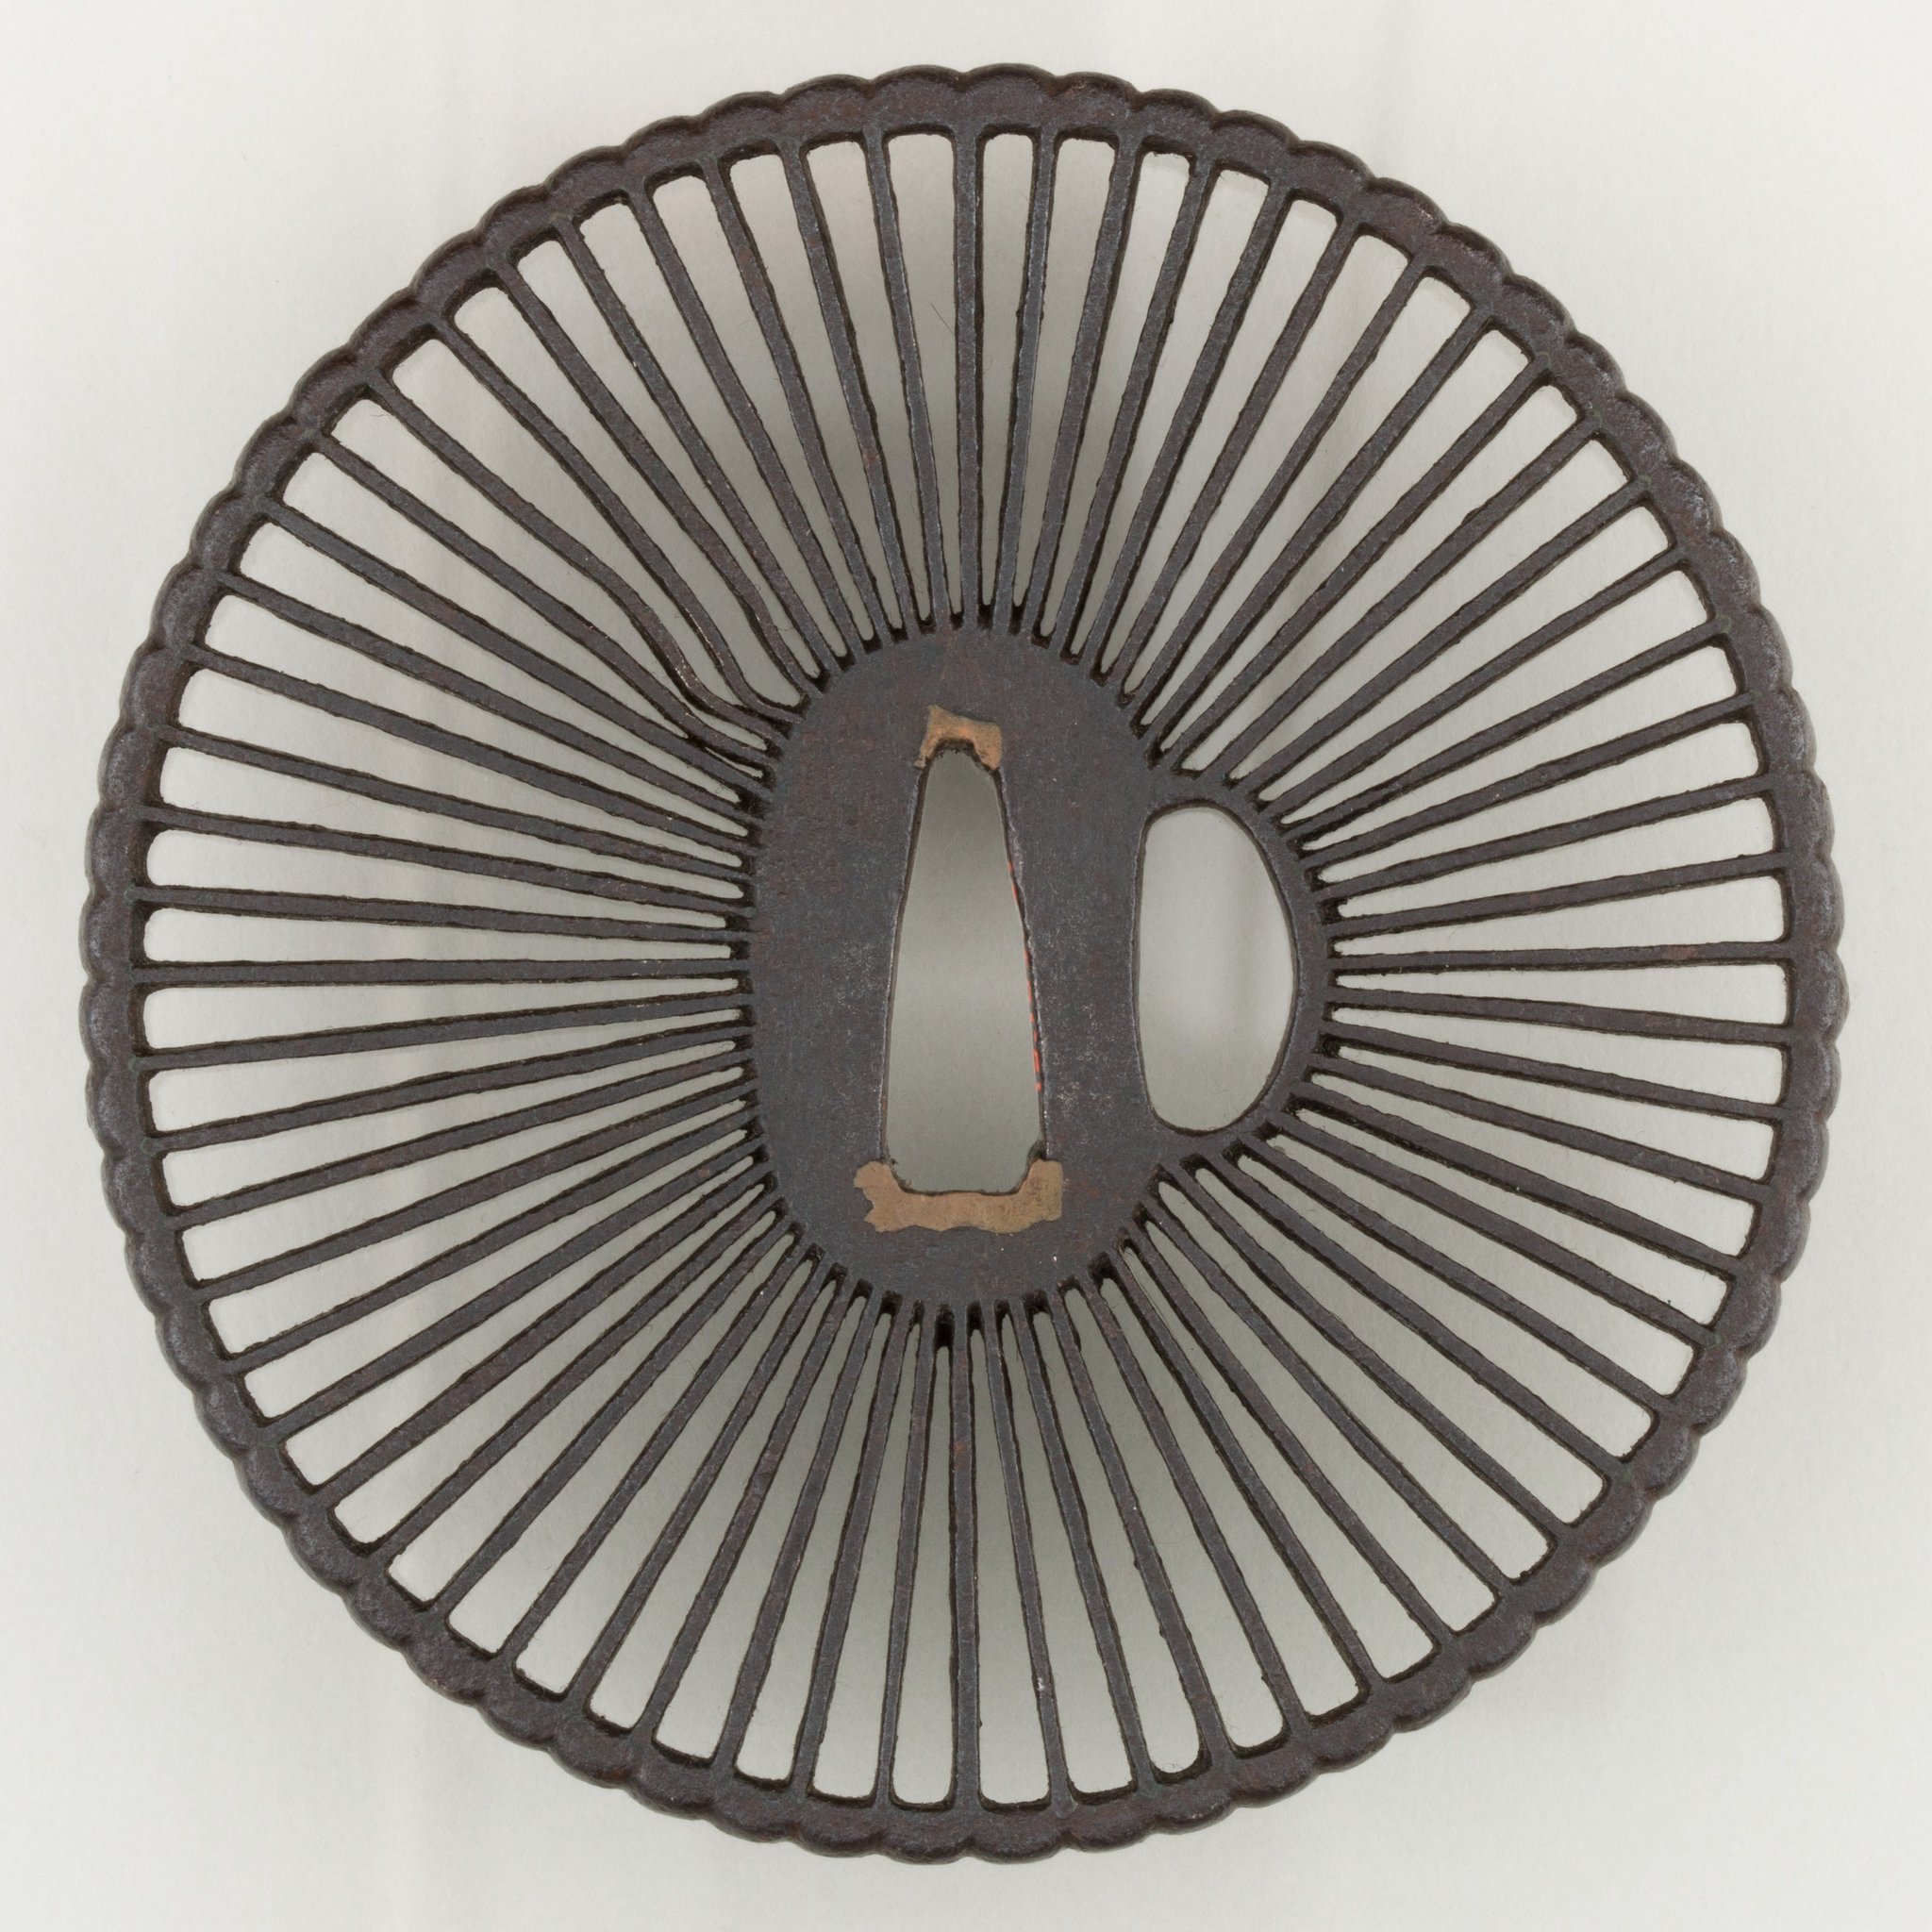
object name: sword guard tsuba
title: Sword Guard (Tsuba)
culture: japanese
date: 1600-1700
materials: copper, iron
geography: japan